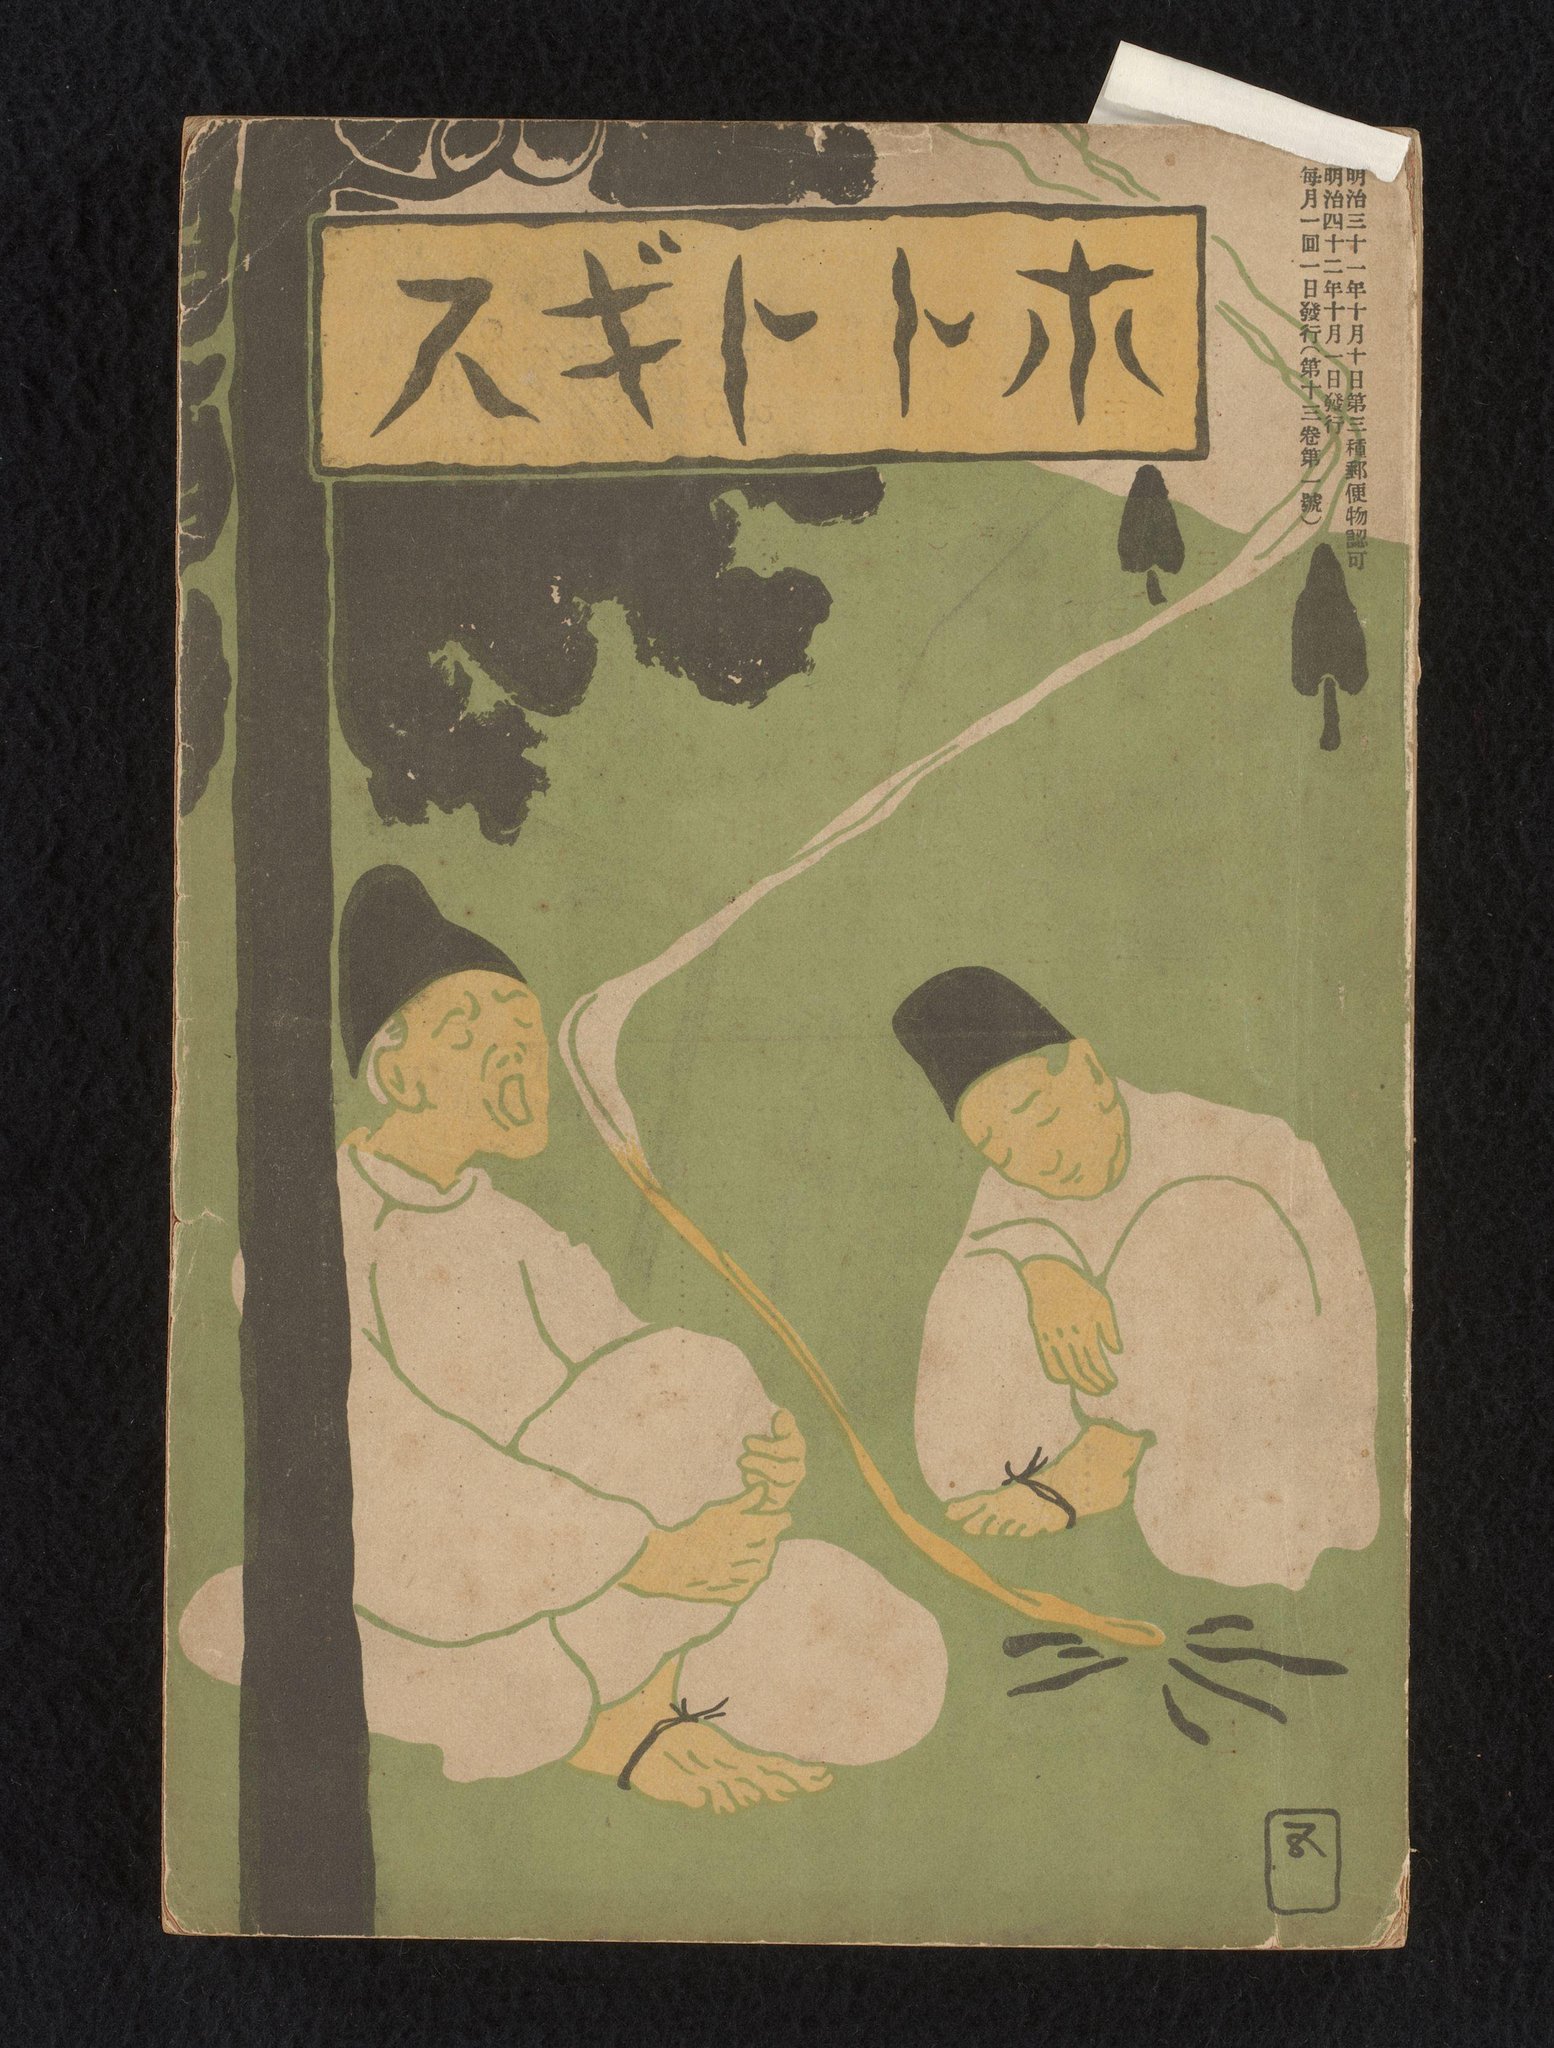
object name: magazine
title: Hototogisu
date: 1909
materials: paper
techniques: woodcut, letterpress printing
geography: japan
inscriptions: date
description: Ontwerp titelplaat: Hashiguchi Goyô. Overige illustraties: Shimomura Izan (1), Okamoto Gesson (10), Ishii Hakutei (7), Miyazaki Yohei (7), Akashi Akago (?) (1), Shitsu Meiko (?) (1), "Hebi Otoko" (1), Matsushita Reirei (1), Ibaragi Fusen (1), [Kinoshita] Shigeru (1) en Toga Musei (1).